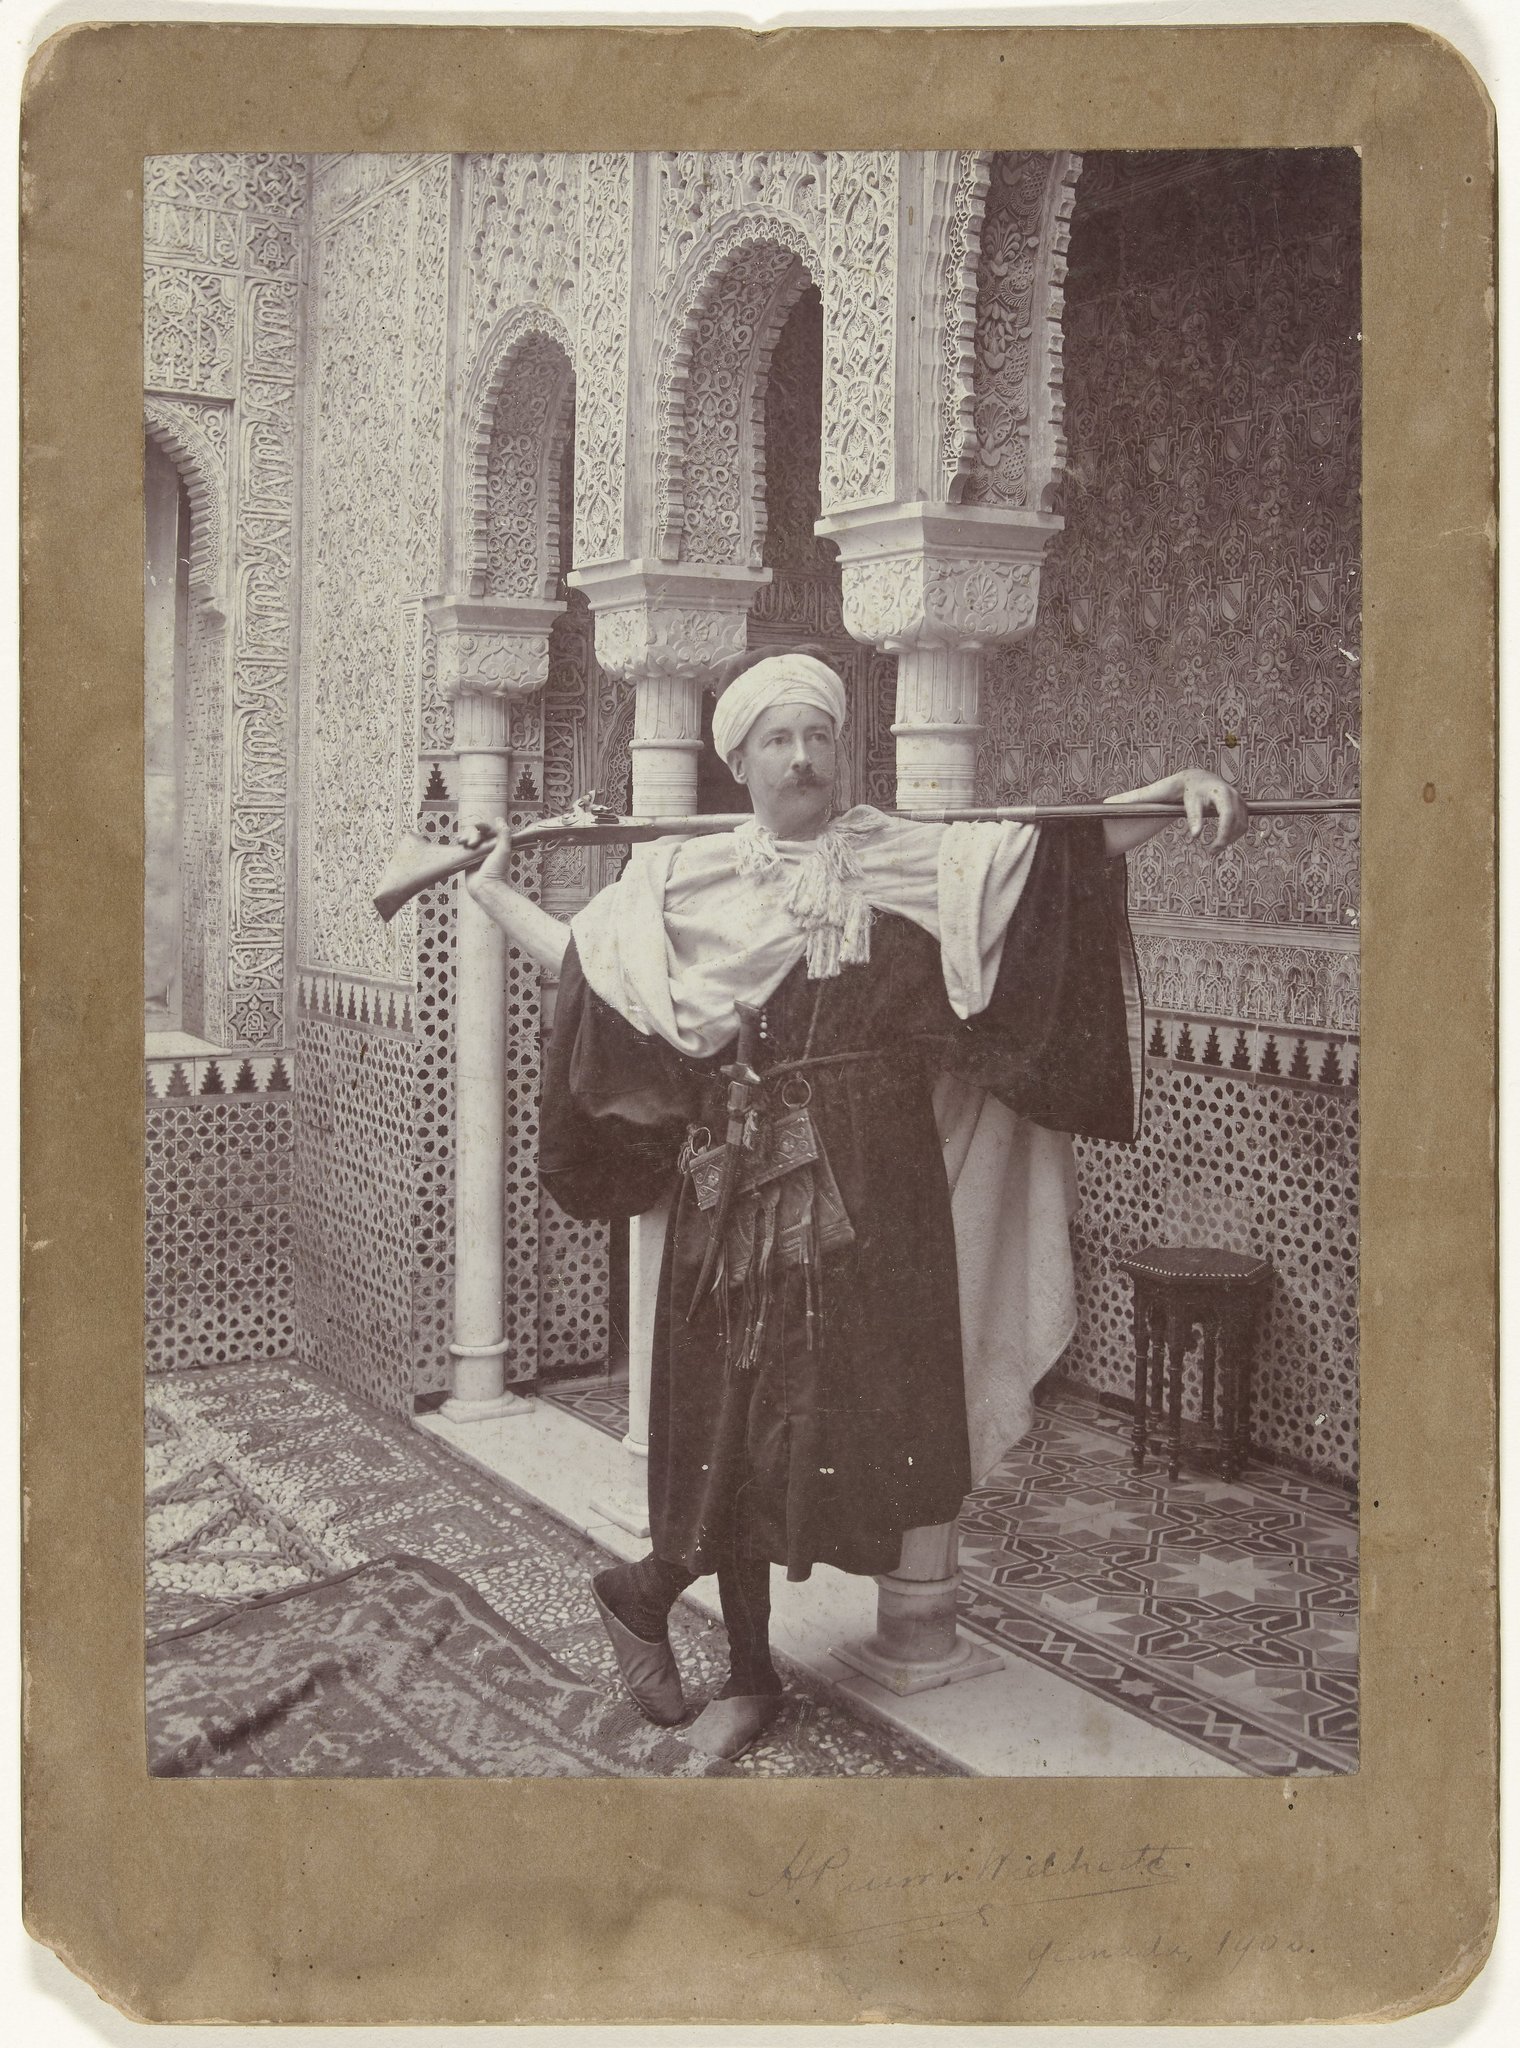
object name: photograph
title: Zelfportret in Oriëntaals kostuum met een geweer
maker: rafael garzón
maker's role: publisher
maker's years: 1863-1923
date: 1902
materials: cardboard, photographic support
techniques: collodion silver print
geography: granada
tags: granada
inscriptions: signature and date: ‘H. Pauw v. Wieldrecht. / Granada, 1902.’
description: In de mozaïkvloer van de studio, in de stijl van het Alhambra, is een deel van de naam van de fotograaf te lezen: Rafael G[arzón].